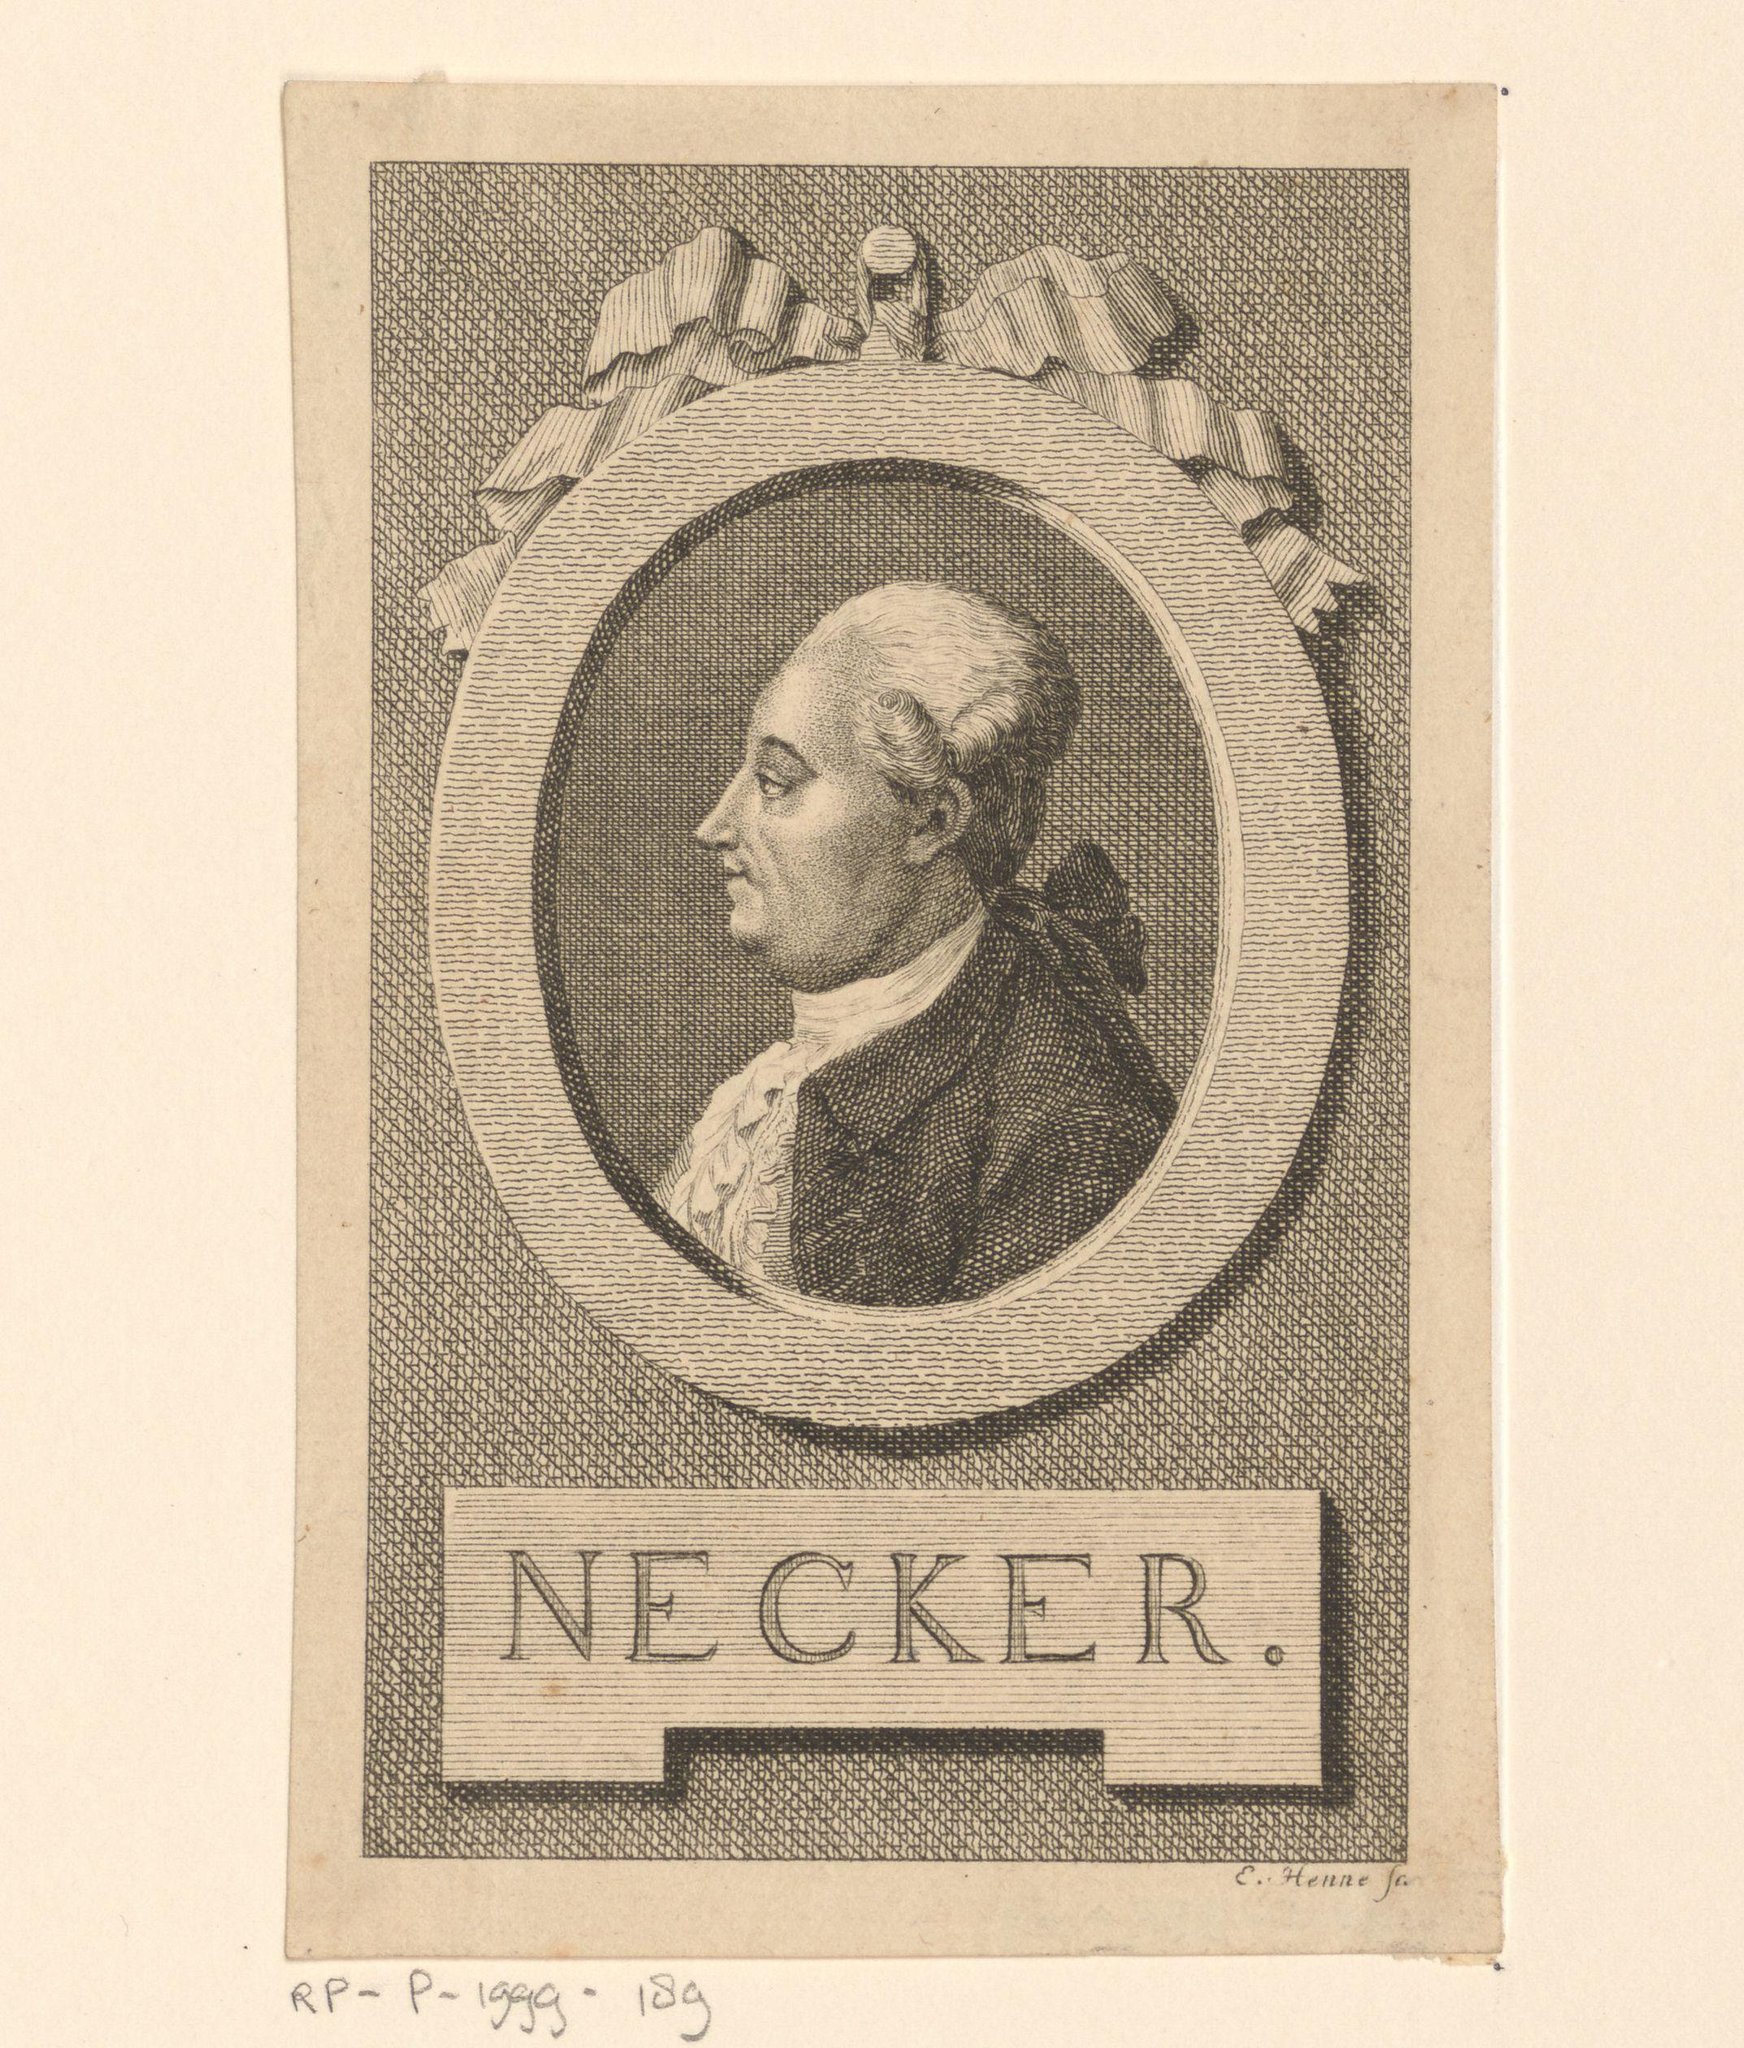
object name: print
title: Portret van Jacques Necker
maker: eberhard siegfried henne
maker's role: print maker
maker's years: 1759-1828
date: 1782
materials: paper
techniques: engraving, etching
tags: minister ~ government, historical persons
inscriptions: collector's mark: Lugt 2228, collector's mark: Lugt 2760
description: Prent waarschijnlijk uit: Historisches Portefeuille 1 (1782), nr. 3, maart 1782.